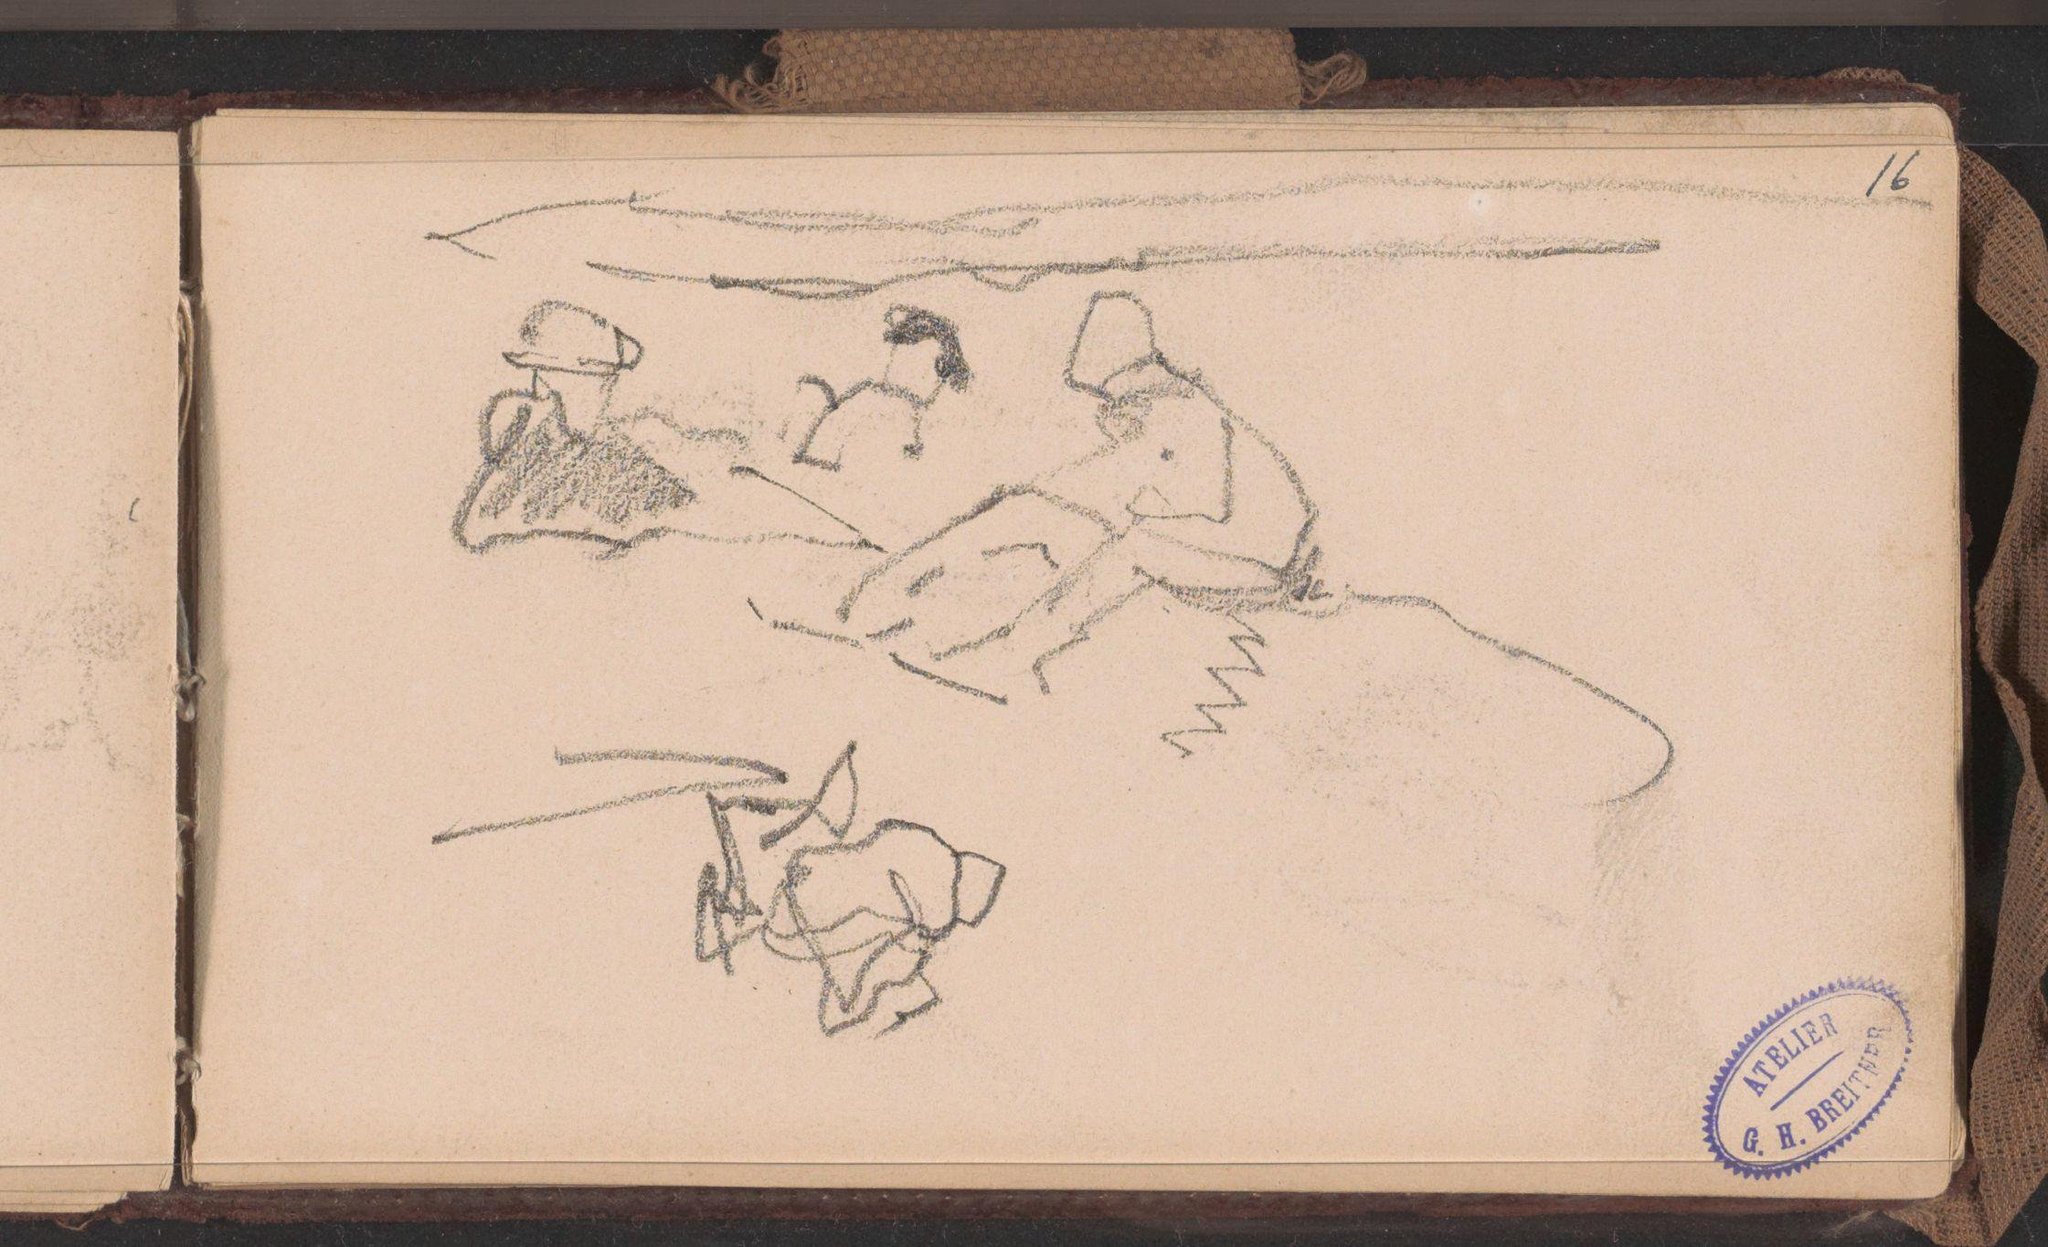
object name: sketchbook leaf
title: Zittende figuren, mogelijk op het strand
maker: george hendrik breitner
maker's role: draughtsman, painter, print maker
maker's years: 1857-1923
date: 1880-1882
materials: paper, pencil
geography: scheveningen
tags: beach (as place of recreation), sitting figure - aa - female human figure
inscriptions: workshop stamp: Lugt 291d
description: Blad 16 recto uit een schetsboek met 16 bladen.